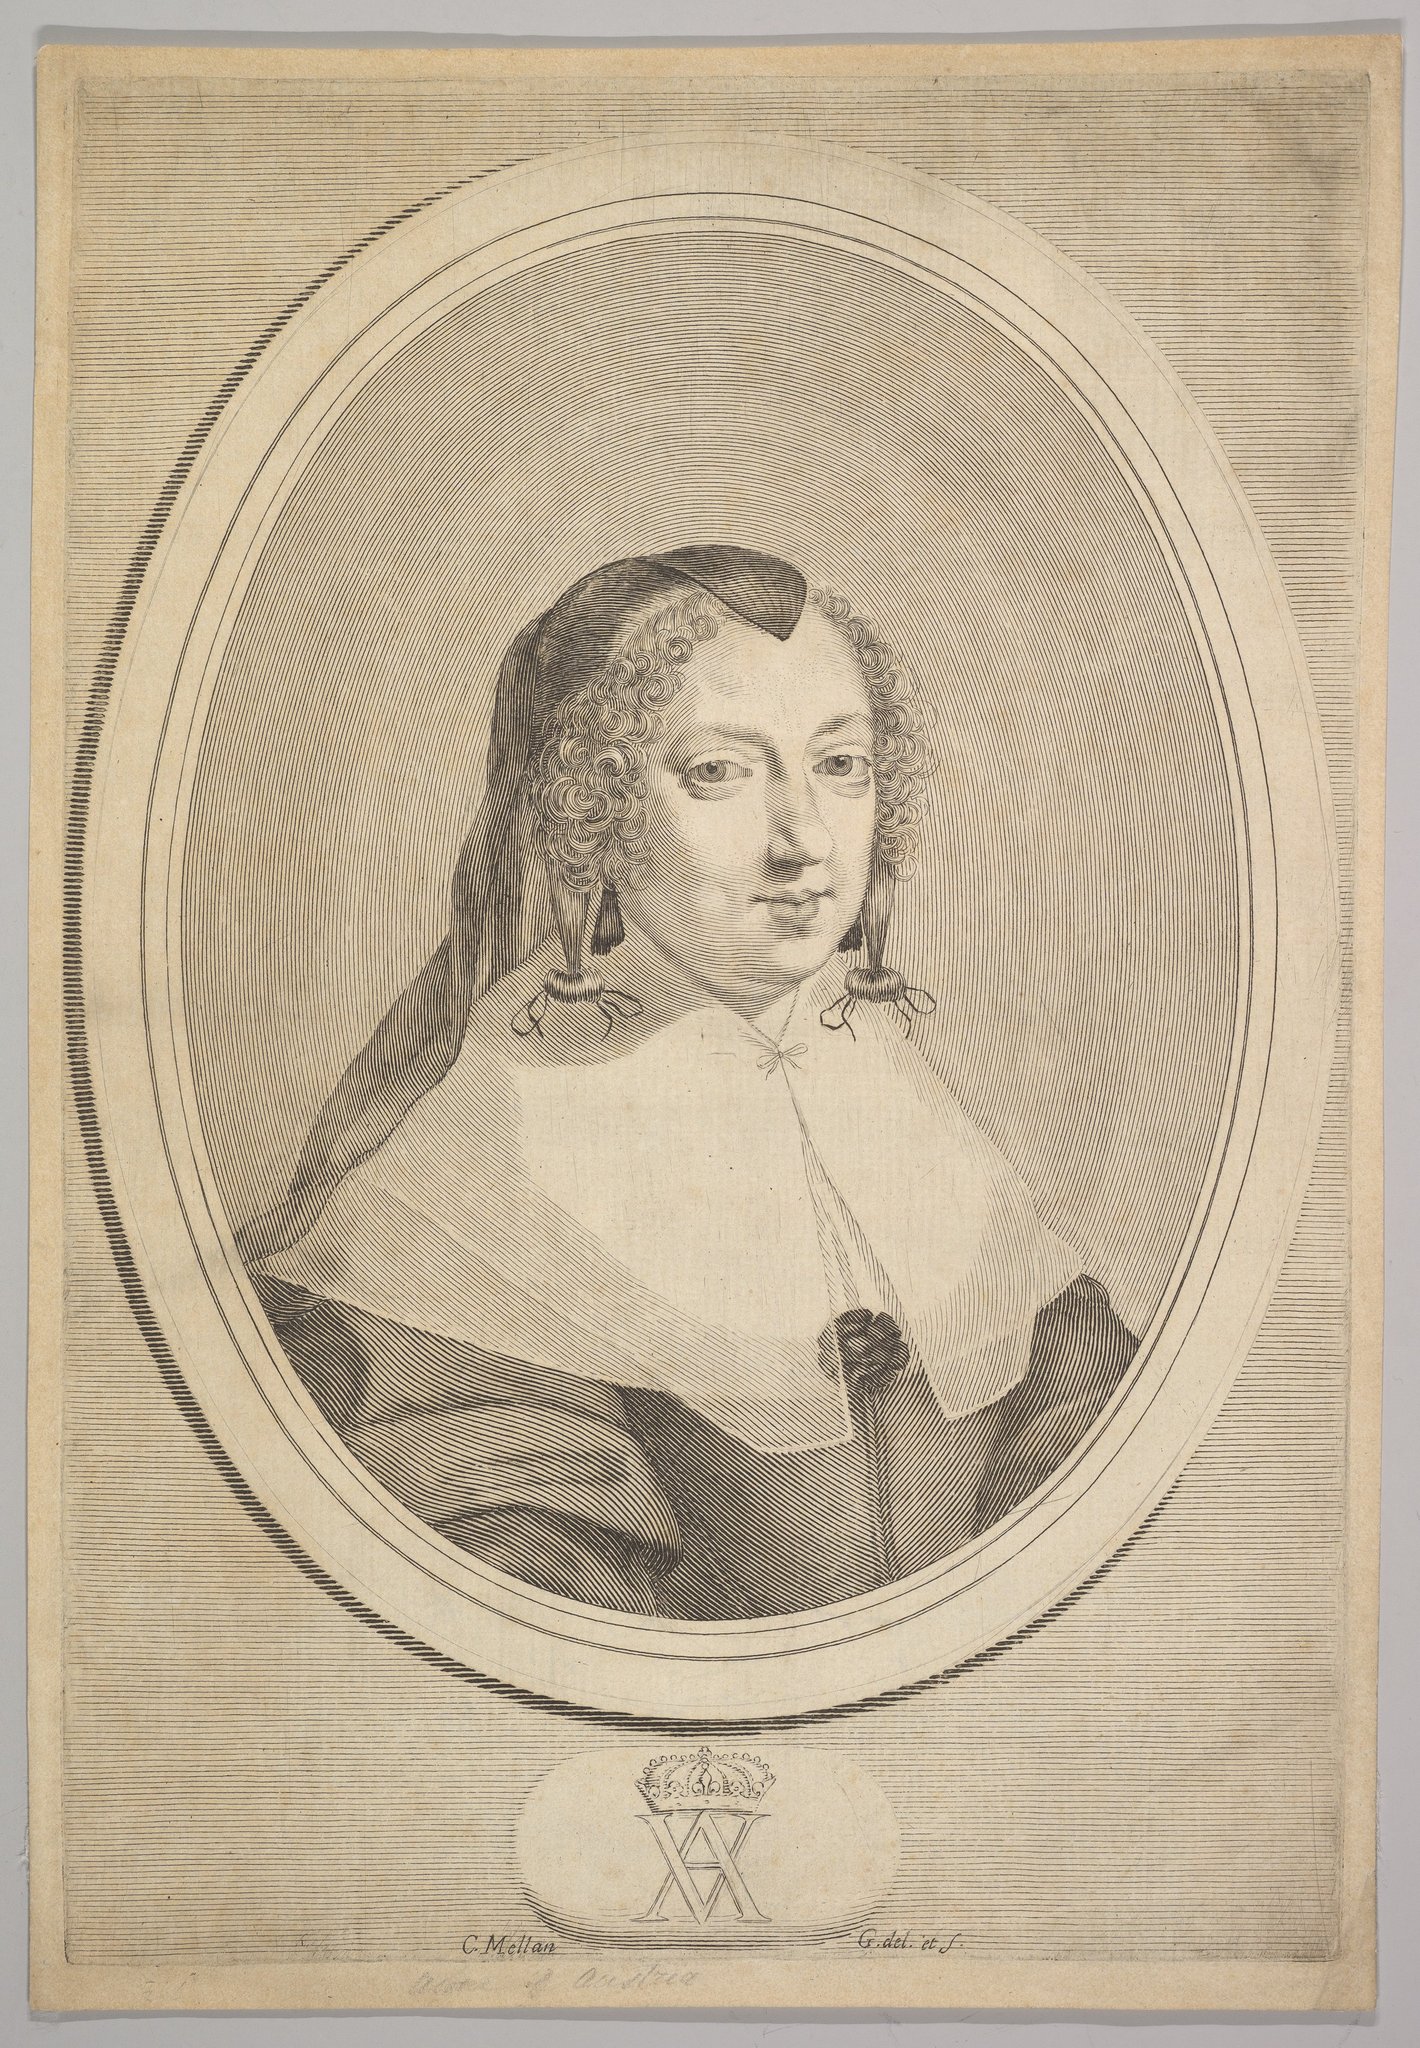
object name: print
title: Anne of Austria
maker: claude mellan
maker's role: artist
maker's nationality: french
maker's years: 1598-1688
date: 1645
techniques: engraving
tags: portraits,women